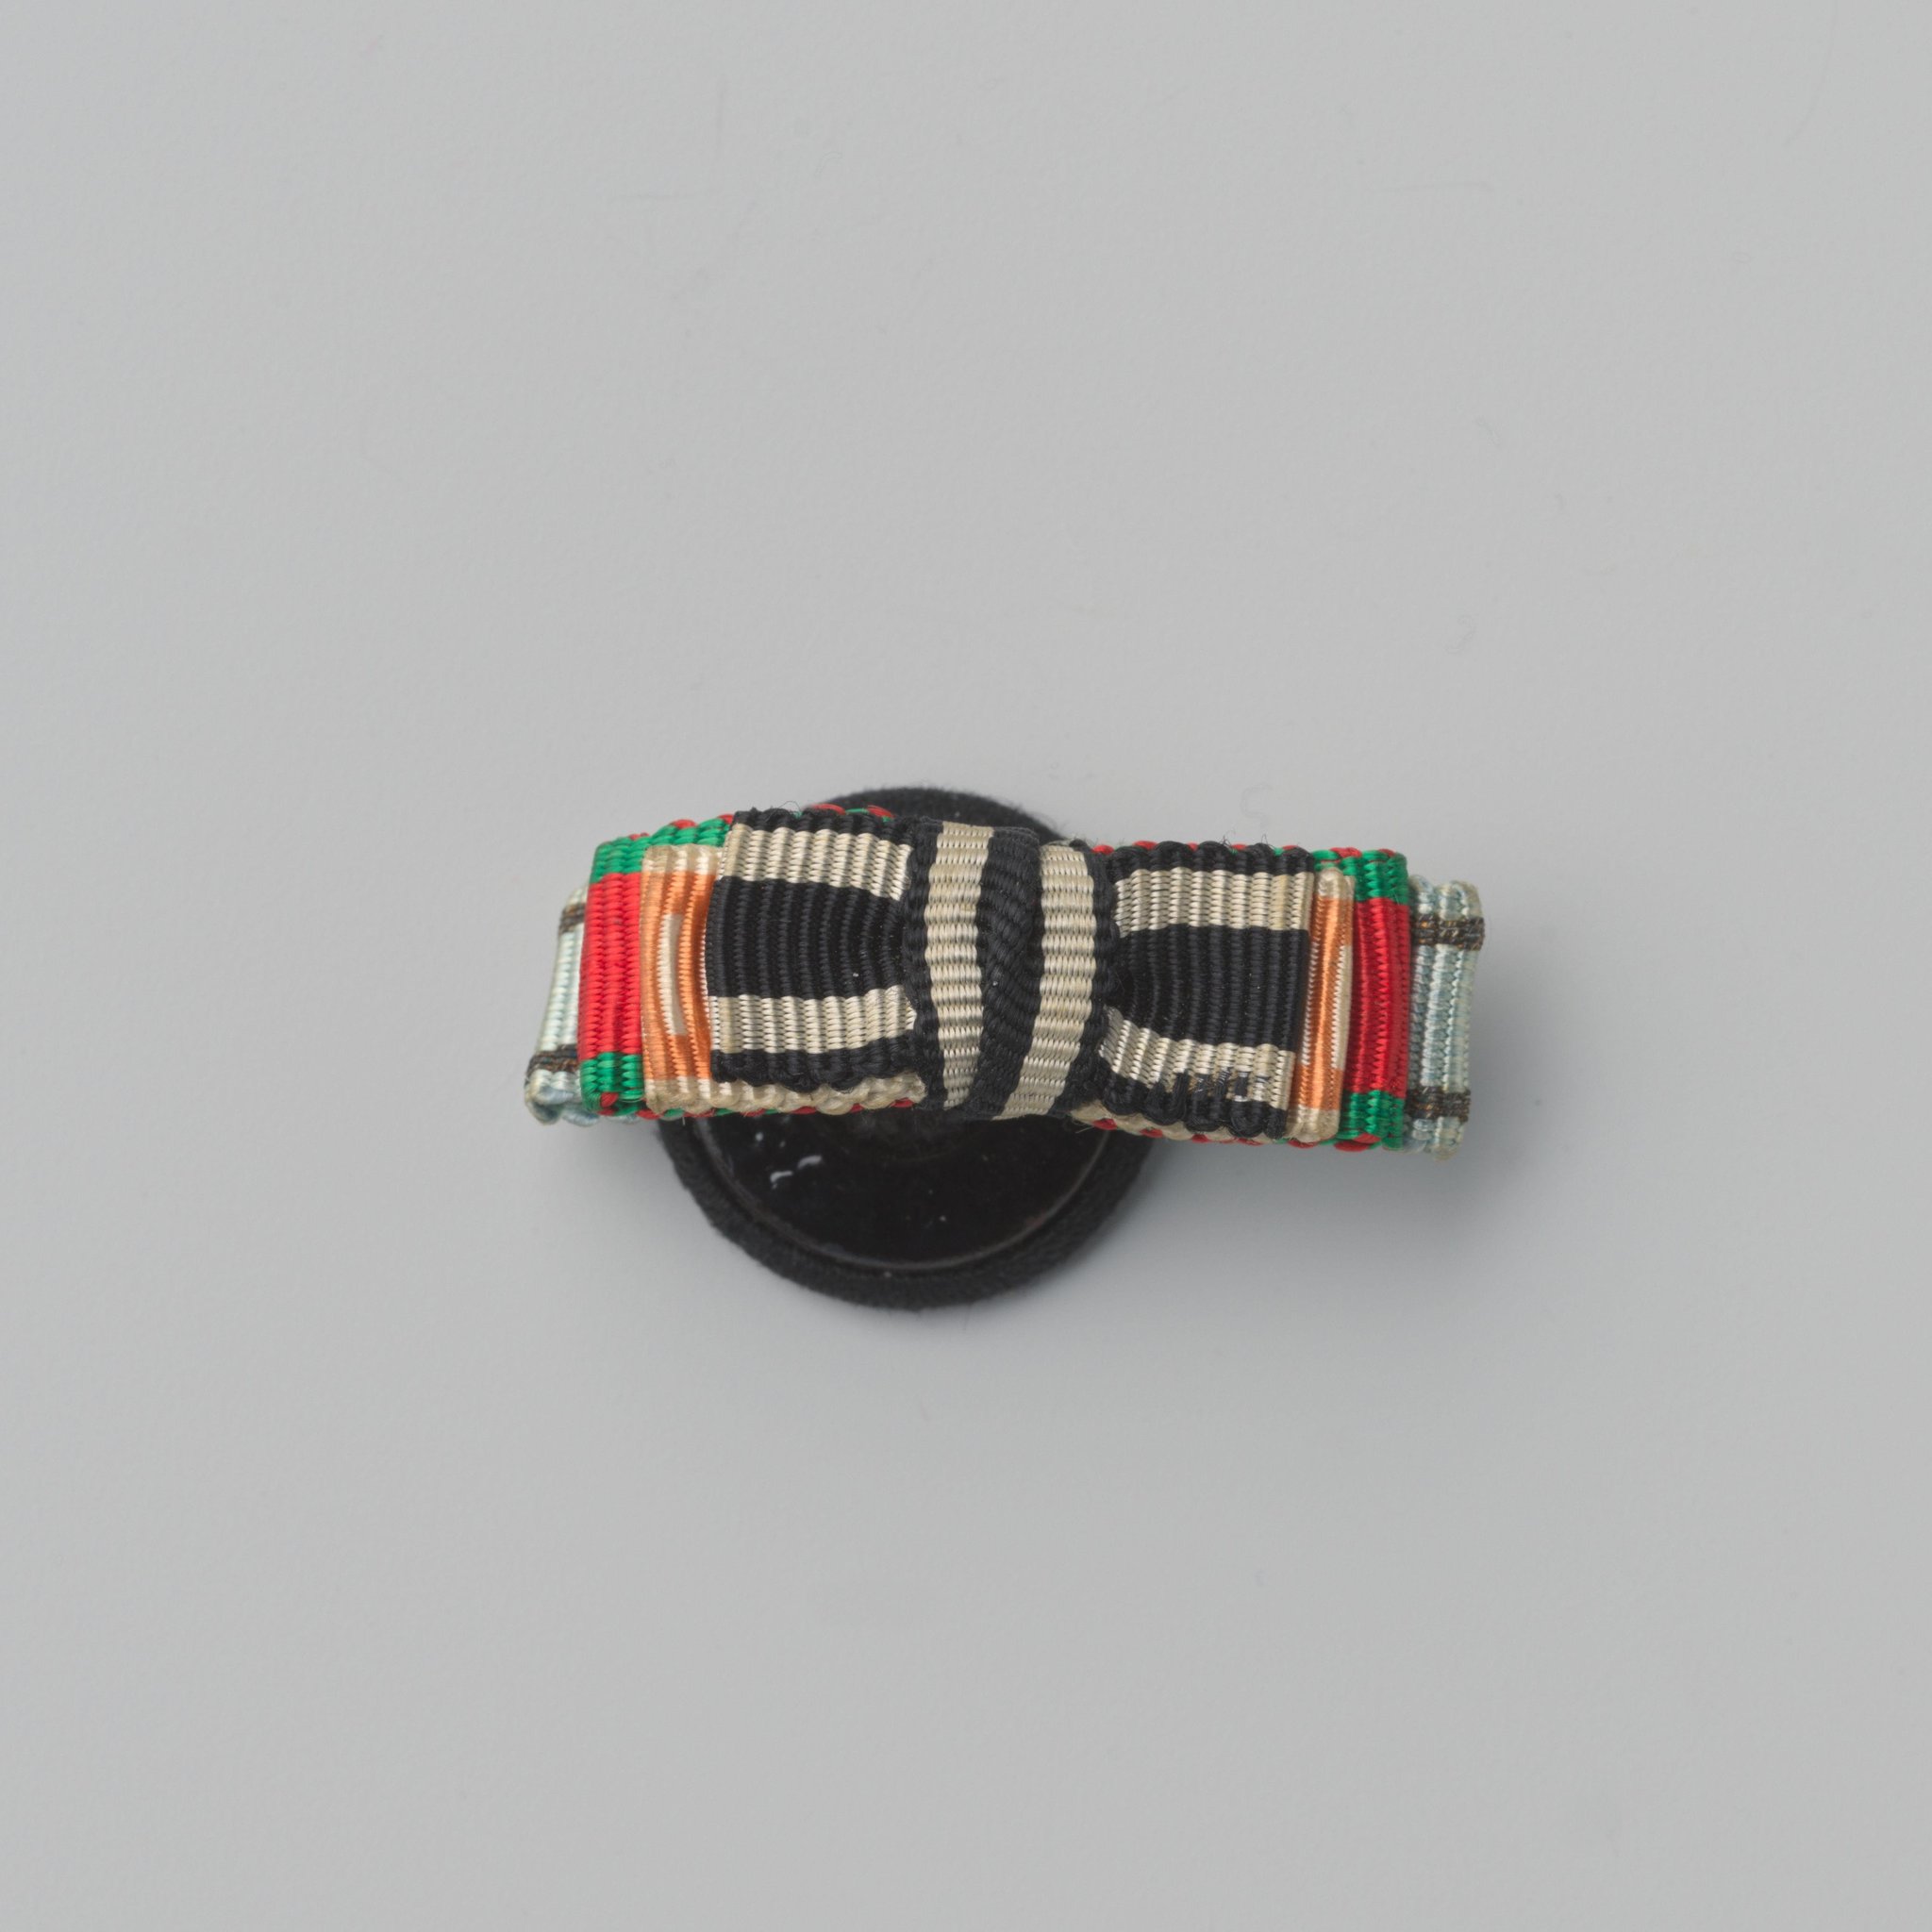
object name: insignia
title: Draagteken van verschillende militaire en civiele orden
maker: Anonymous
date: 1900-1925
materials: silk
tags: eugen wachenheimer, else wachenheimer-moos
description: Dit object is onderdeel van de nalatenschap van Isabel Elon-Wachenheimer (1928-2010). Tot haar overlijden behoorde het samen met de andere objecten uit de nalatenschap tot haar privédomein van Isabel Wachenheimer. In die particuliere context zijn deze objecten tezamen en individueel aandenkens - aan de jeugd, ouders en familie van Isabel Wachenheimer vóór en tijdens de Shoah en aan haar leven na de Tweede Wereldoorlog. Isabel Wachenheimer, die van juni 1943 tot mei 1945 gevangen zat in Kamp Westerbork, Theresienstadt, Auschwitz, Lenzing a/d Oberdonau (een buitenkamp van Mauthausen), overleefde de Shoah. Haar ouders – Eugène Wachenheimer en Else Wachenheimer-Moos - werden op 14 oktober 1944 in Auschwitz-Birkenau vermoord.